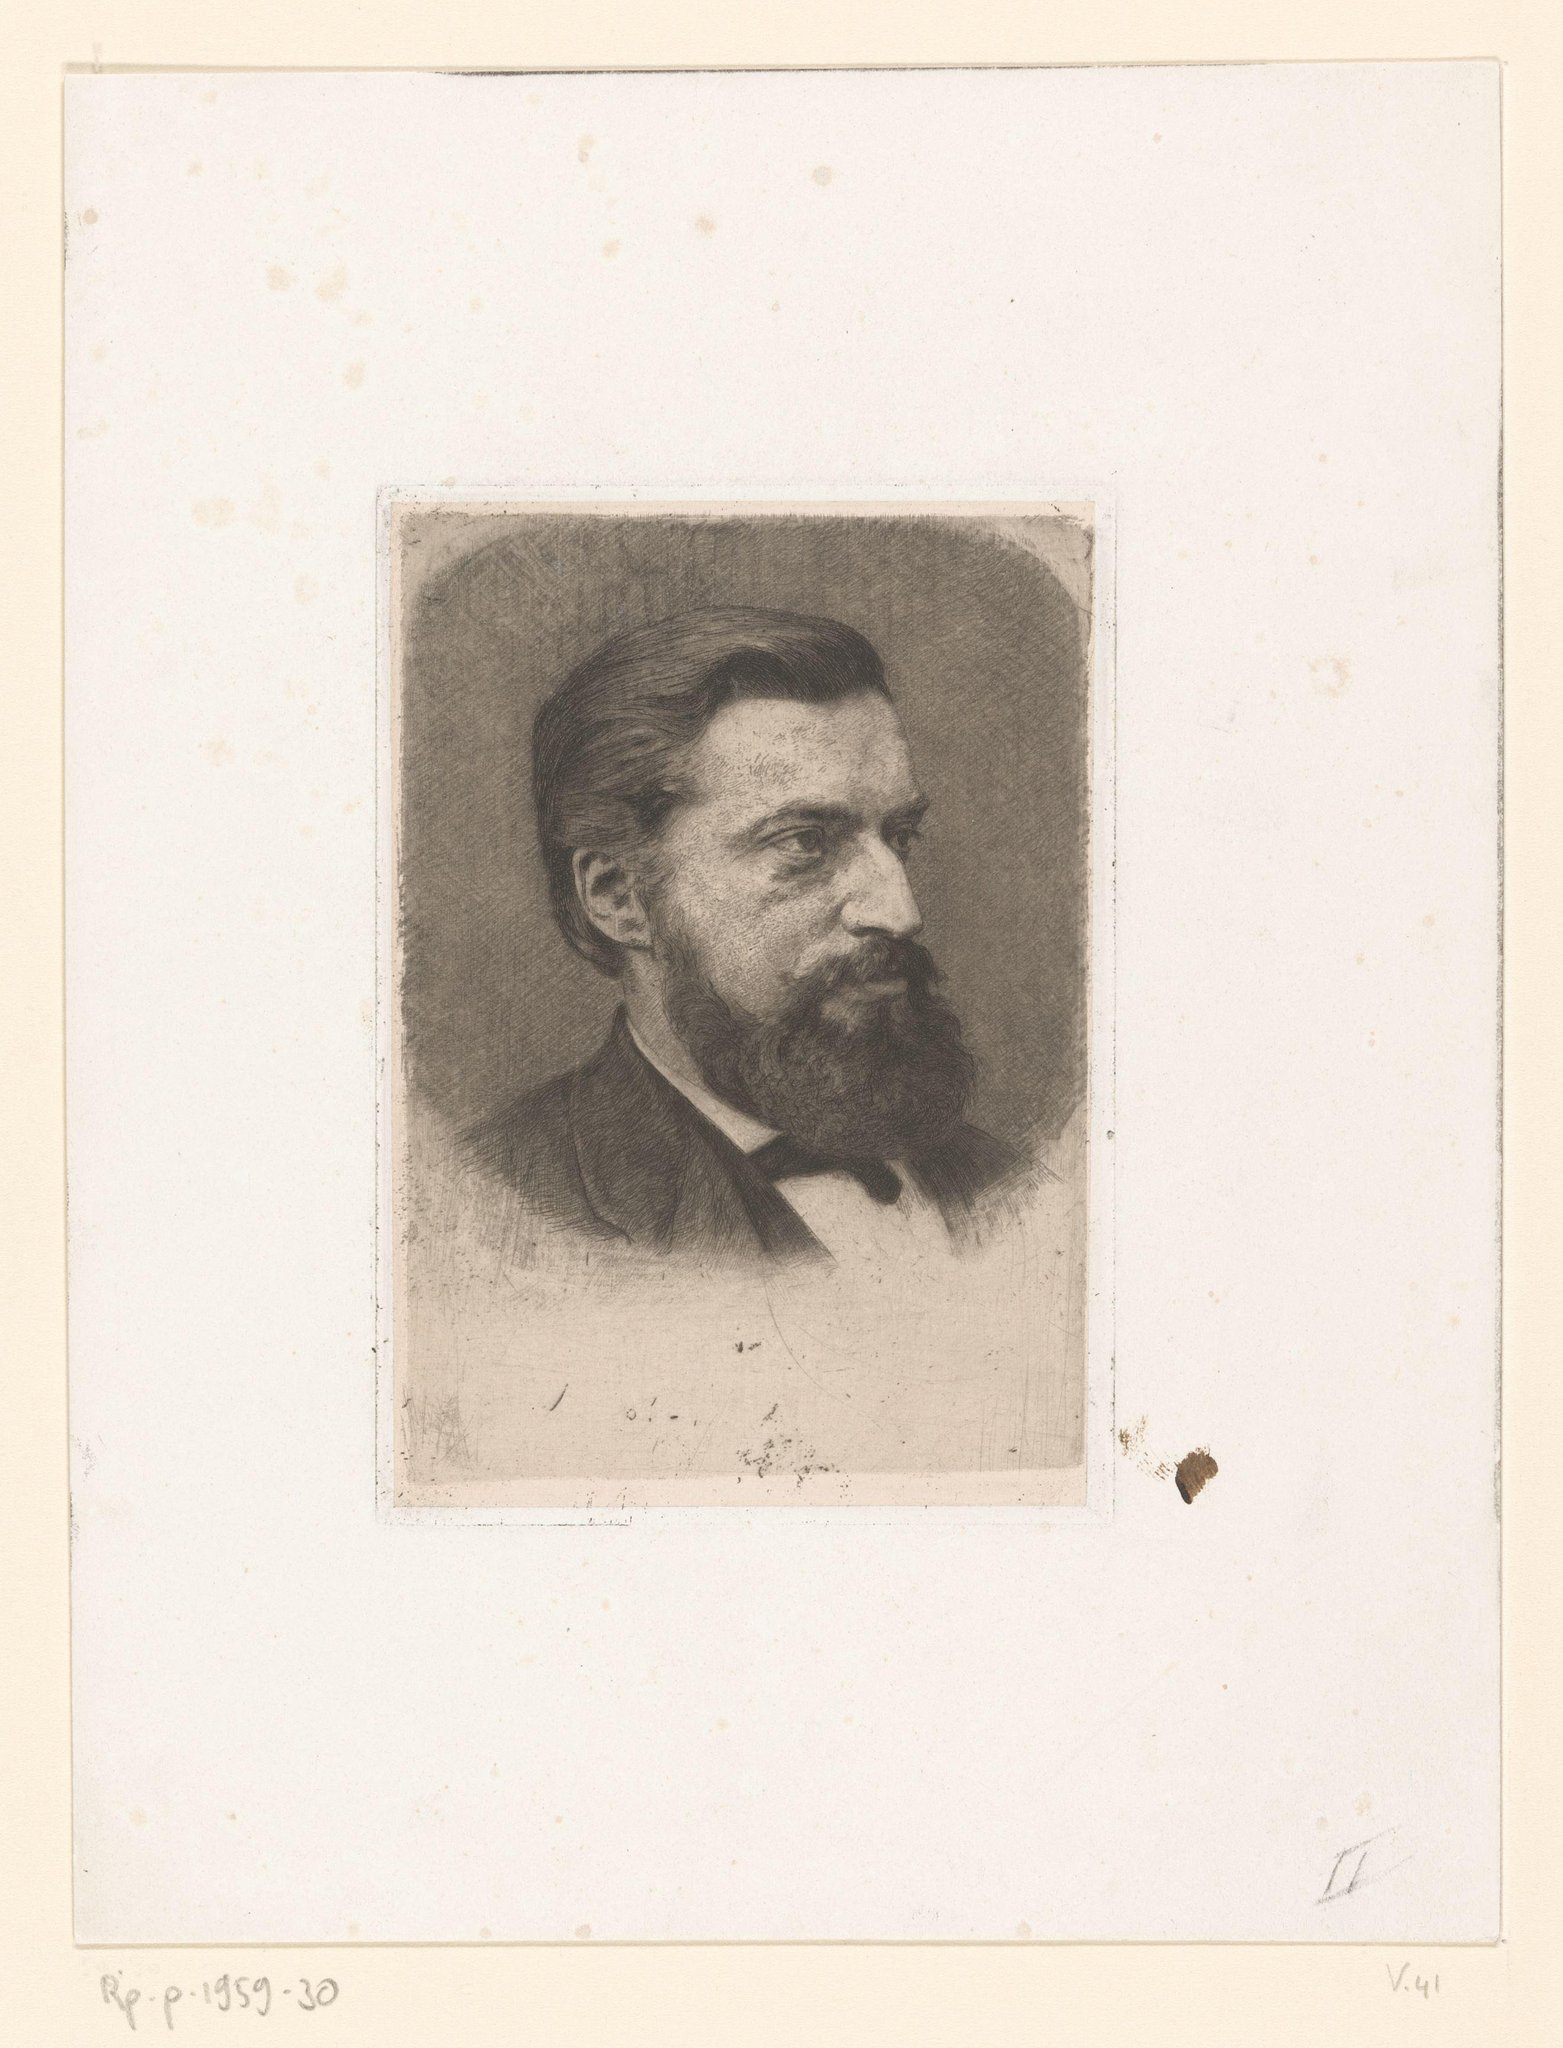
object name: print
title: Portret van Thomas Theodorus Hendrikus Jorissen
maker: jan veth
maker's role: designer, draughtsman, painter, print maker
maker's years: 1864-1925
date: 1891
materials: paper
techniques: drypoint, etching, intaglio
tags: utrecht, amsterdam, historical persons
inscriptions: collector's mark: Lugt 2228